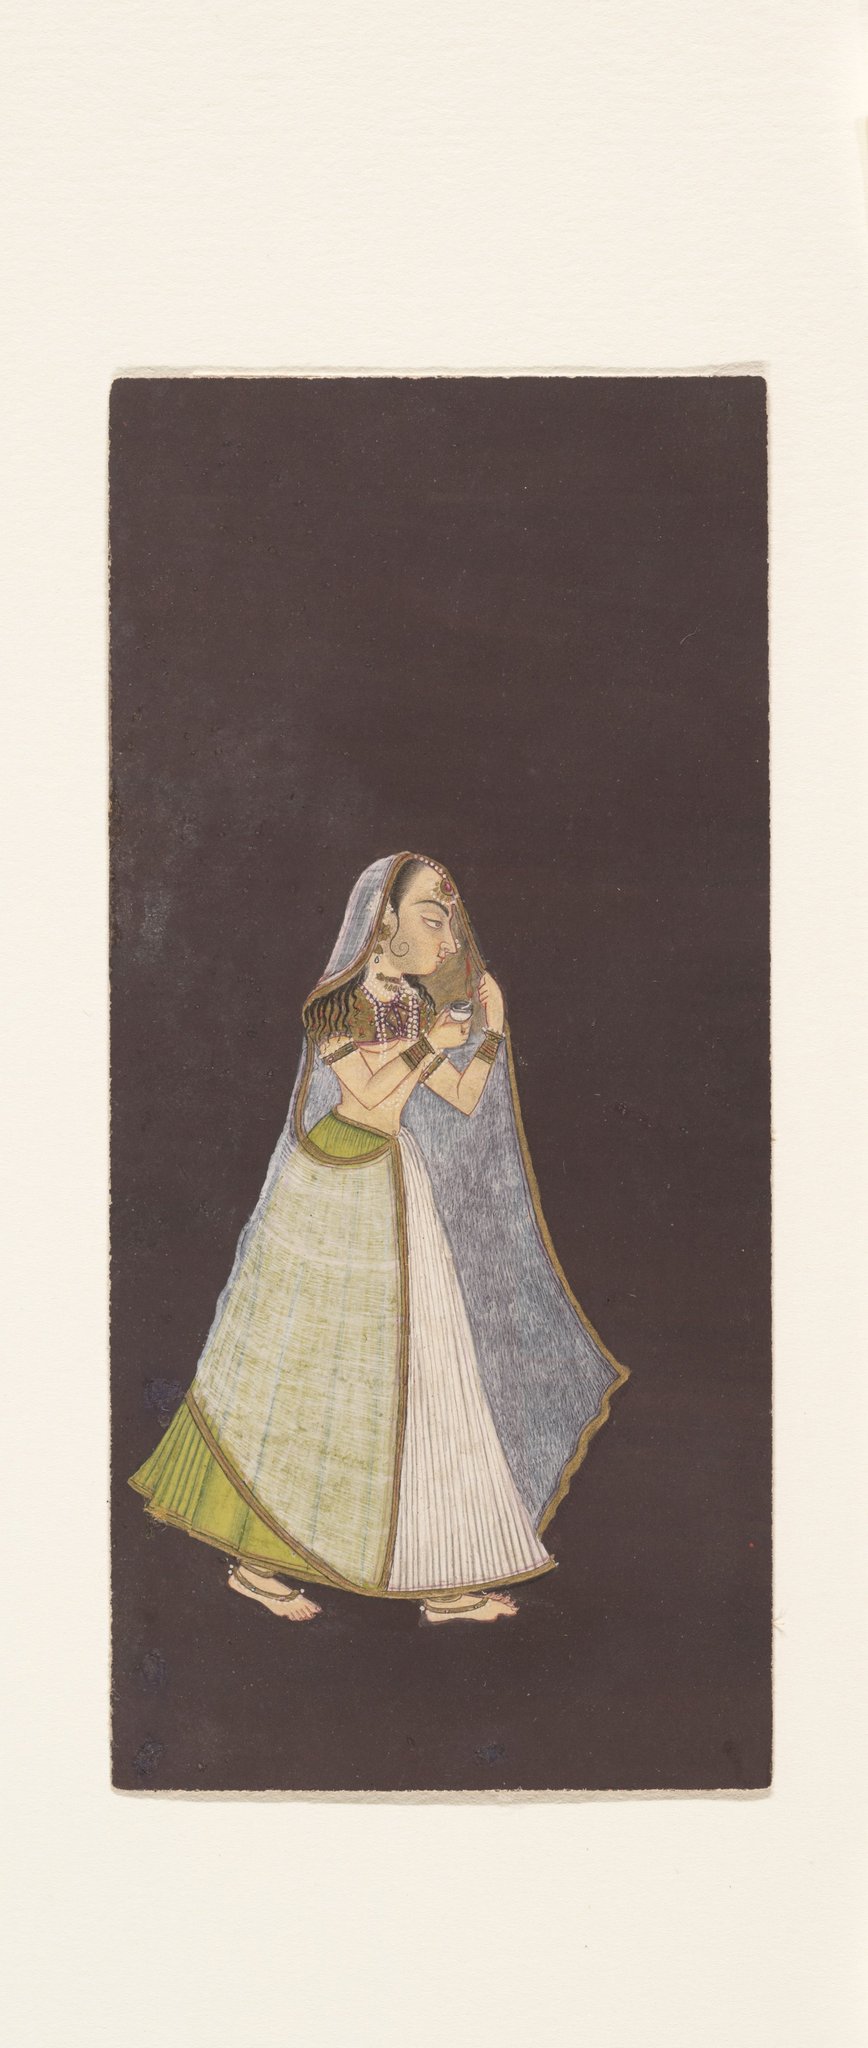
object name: painting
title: A Lady Walking at Night Holding an Oil Lamp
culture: indian, rajasthani, bikaner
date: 1725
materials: ink, paper, watercolor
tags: women,lamps